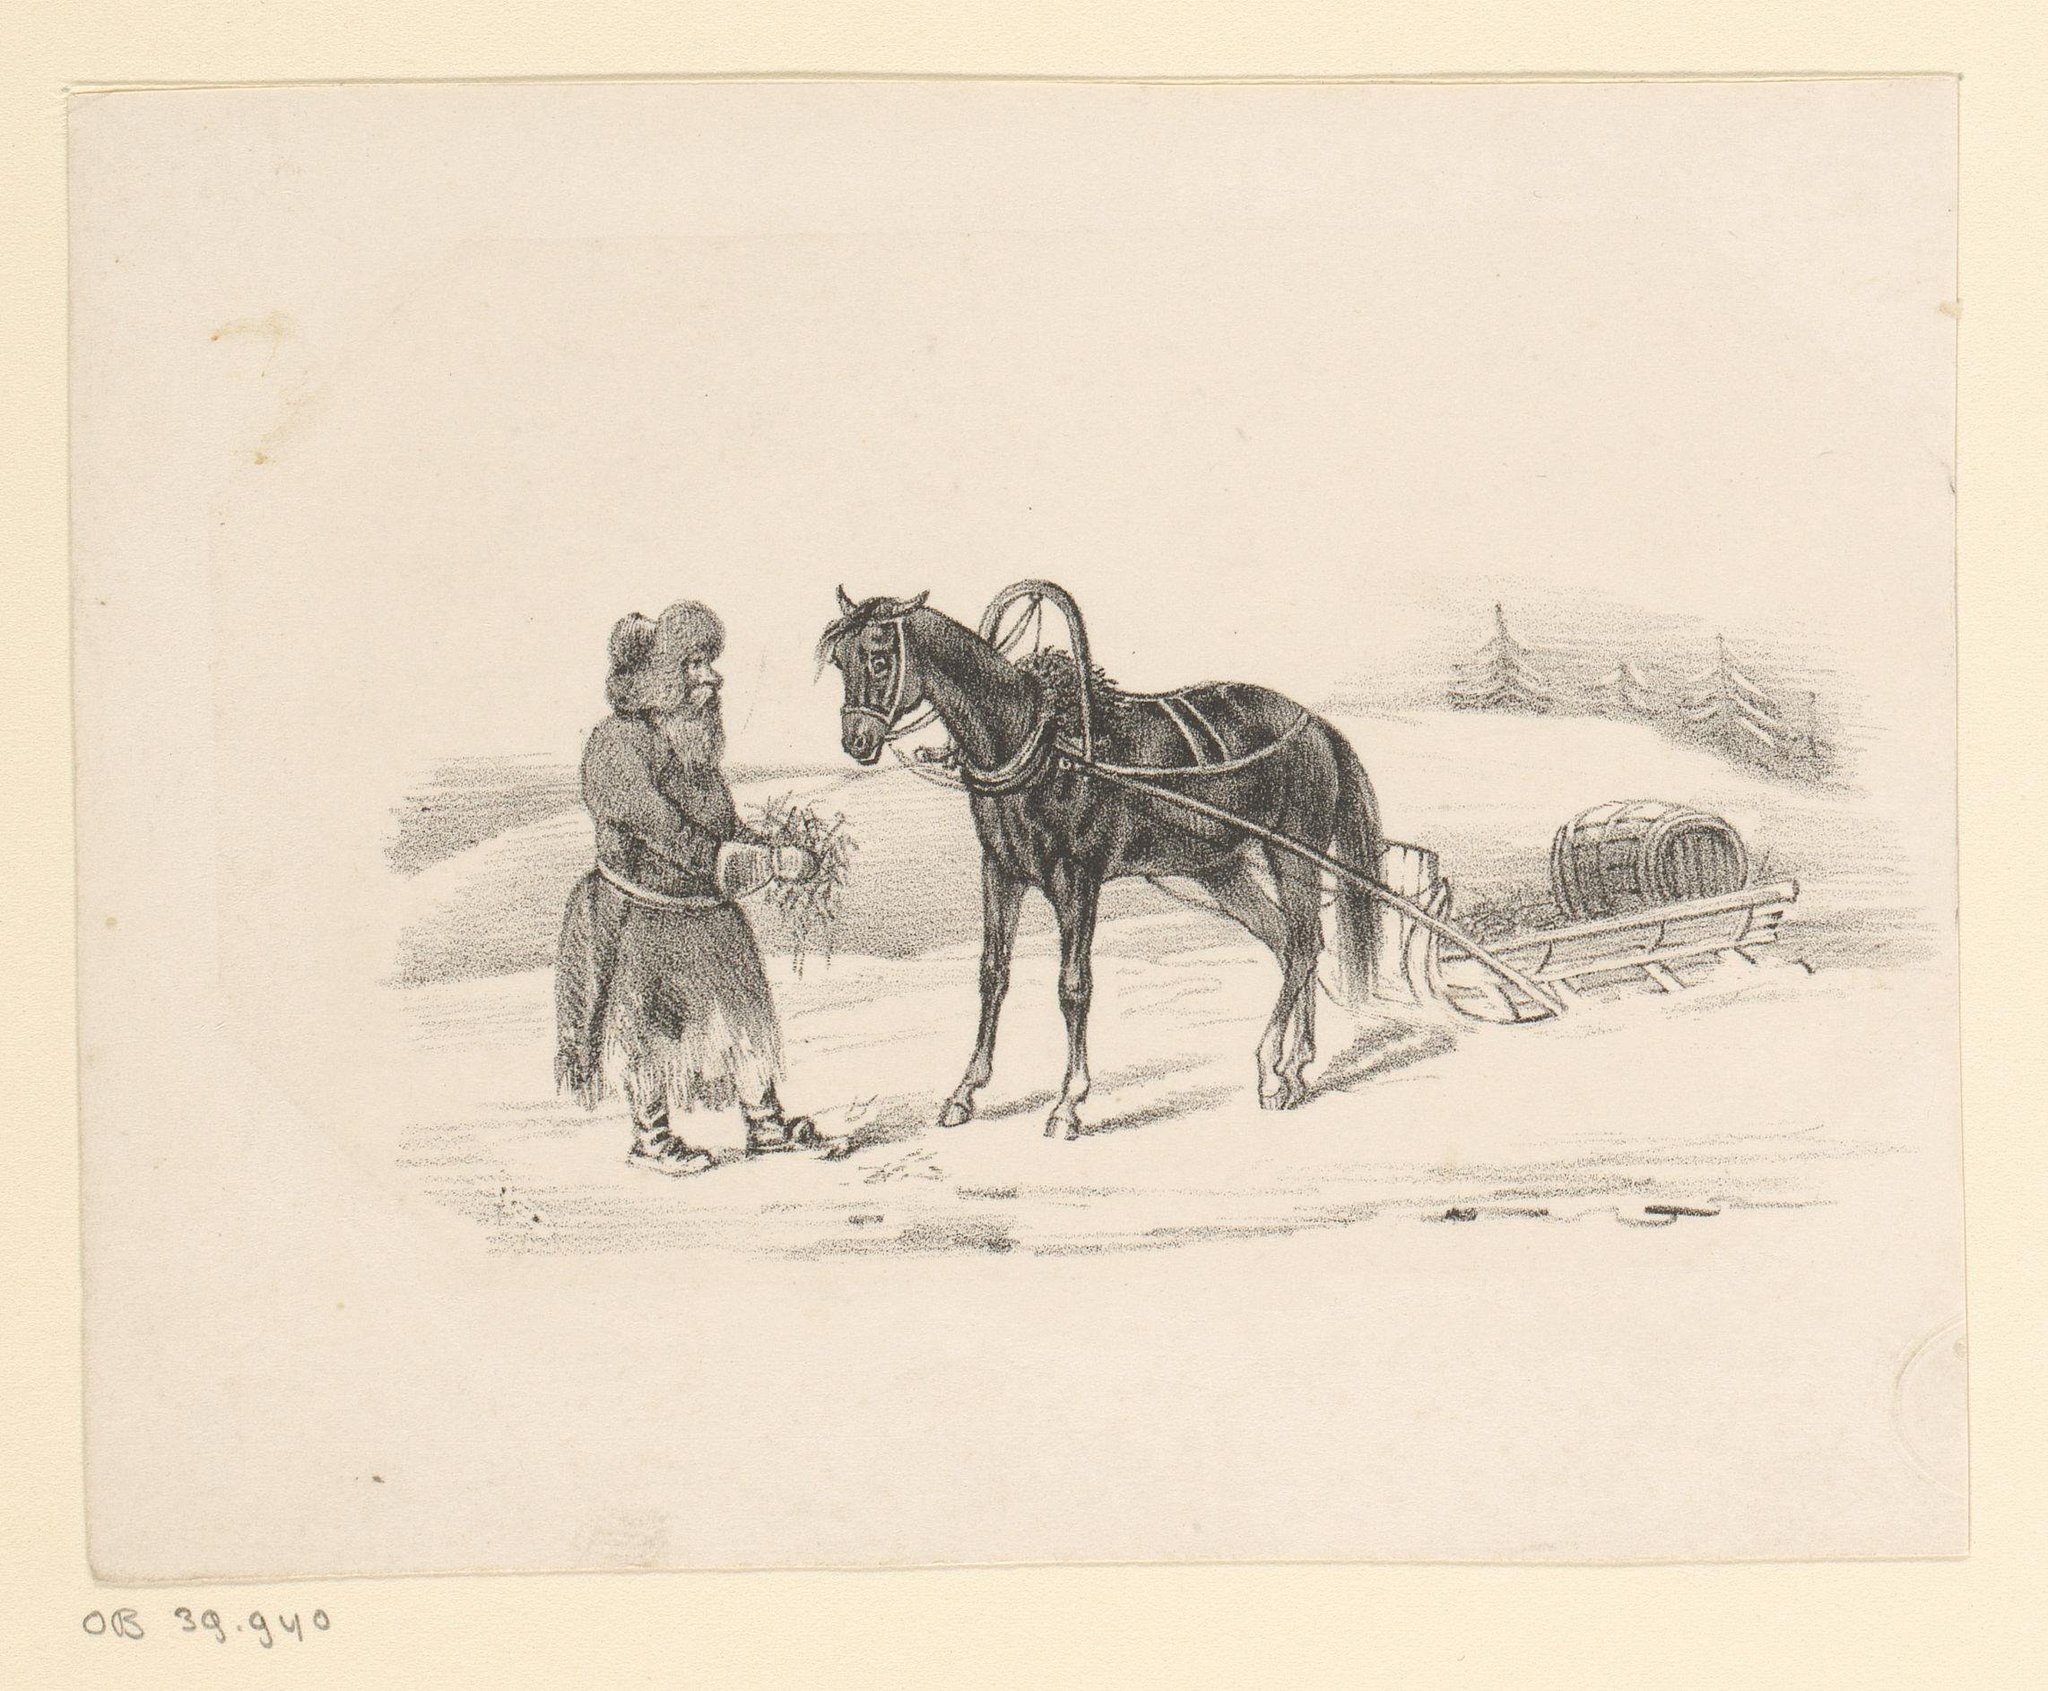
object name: print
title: Man voert een paard met slede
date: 1827-1865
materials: paper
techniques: lithograph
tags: giving food, horse-sleigh, adult man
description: Waarschijnlijk maakte deze prent samen met RP-P-OB-39.937 t/m RP-P-OB-39.941 deel uit van één blad dat later versneden is.